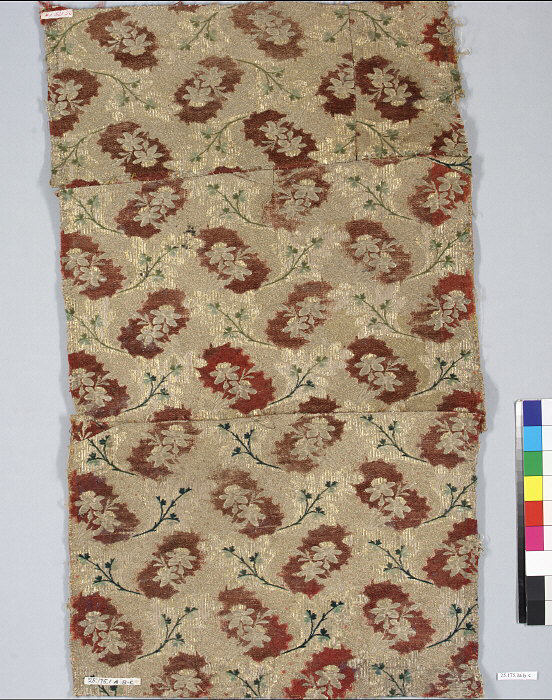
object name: piece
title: Pieces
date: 1750-1800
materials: metal thread, silk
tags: flowers,leaves